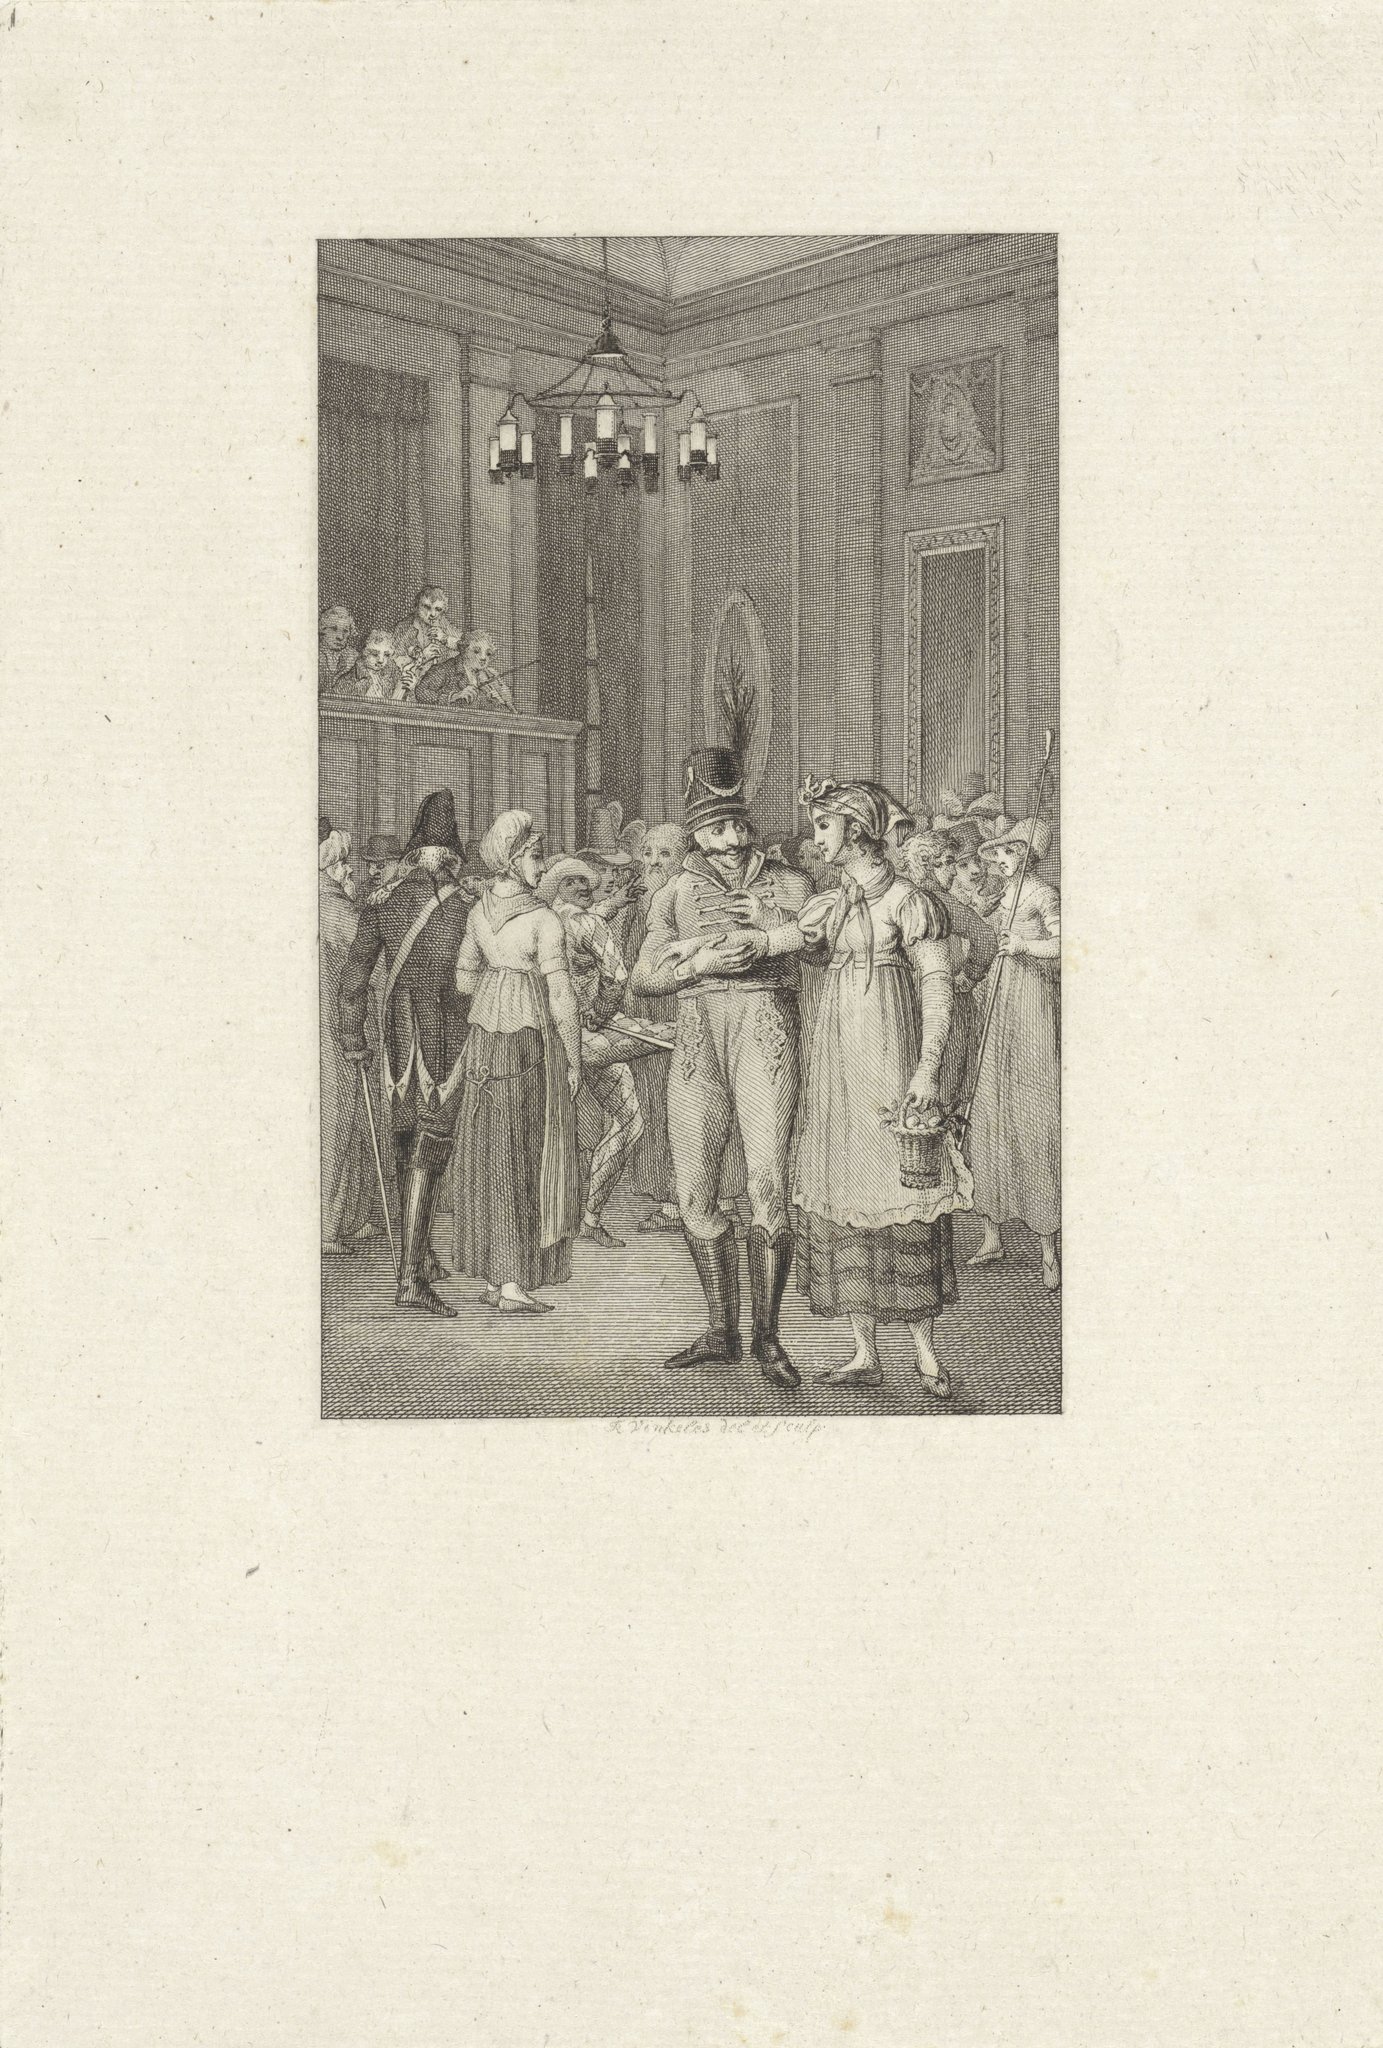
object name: print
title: Gemaskerd bal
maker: reinier vinkeles (i)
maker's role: draughtsman, print maker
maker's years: 1741-1816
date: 1809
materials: paper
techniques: engraving, etching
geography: amsterdam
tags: masquerade, masked ball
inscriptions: collector's mark: Lugt 2228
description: Proefdruk van een prent die ook gebruikt is als illustratie voor: Kist, Wilhelmus. Eduard van Eikenhorst, zijne Huisgenooten en Vrienden. Haarlem: François Bohn, 1809, p. 178-193.